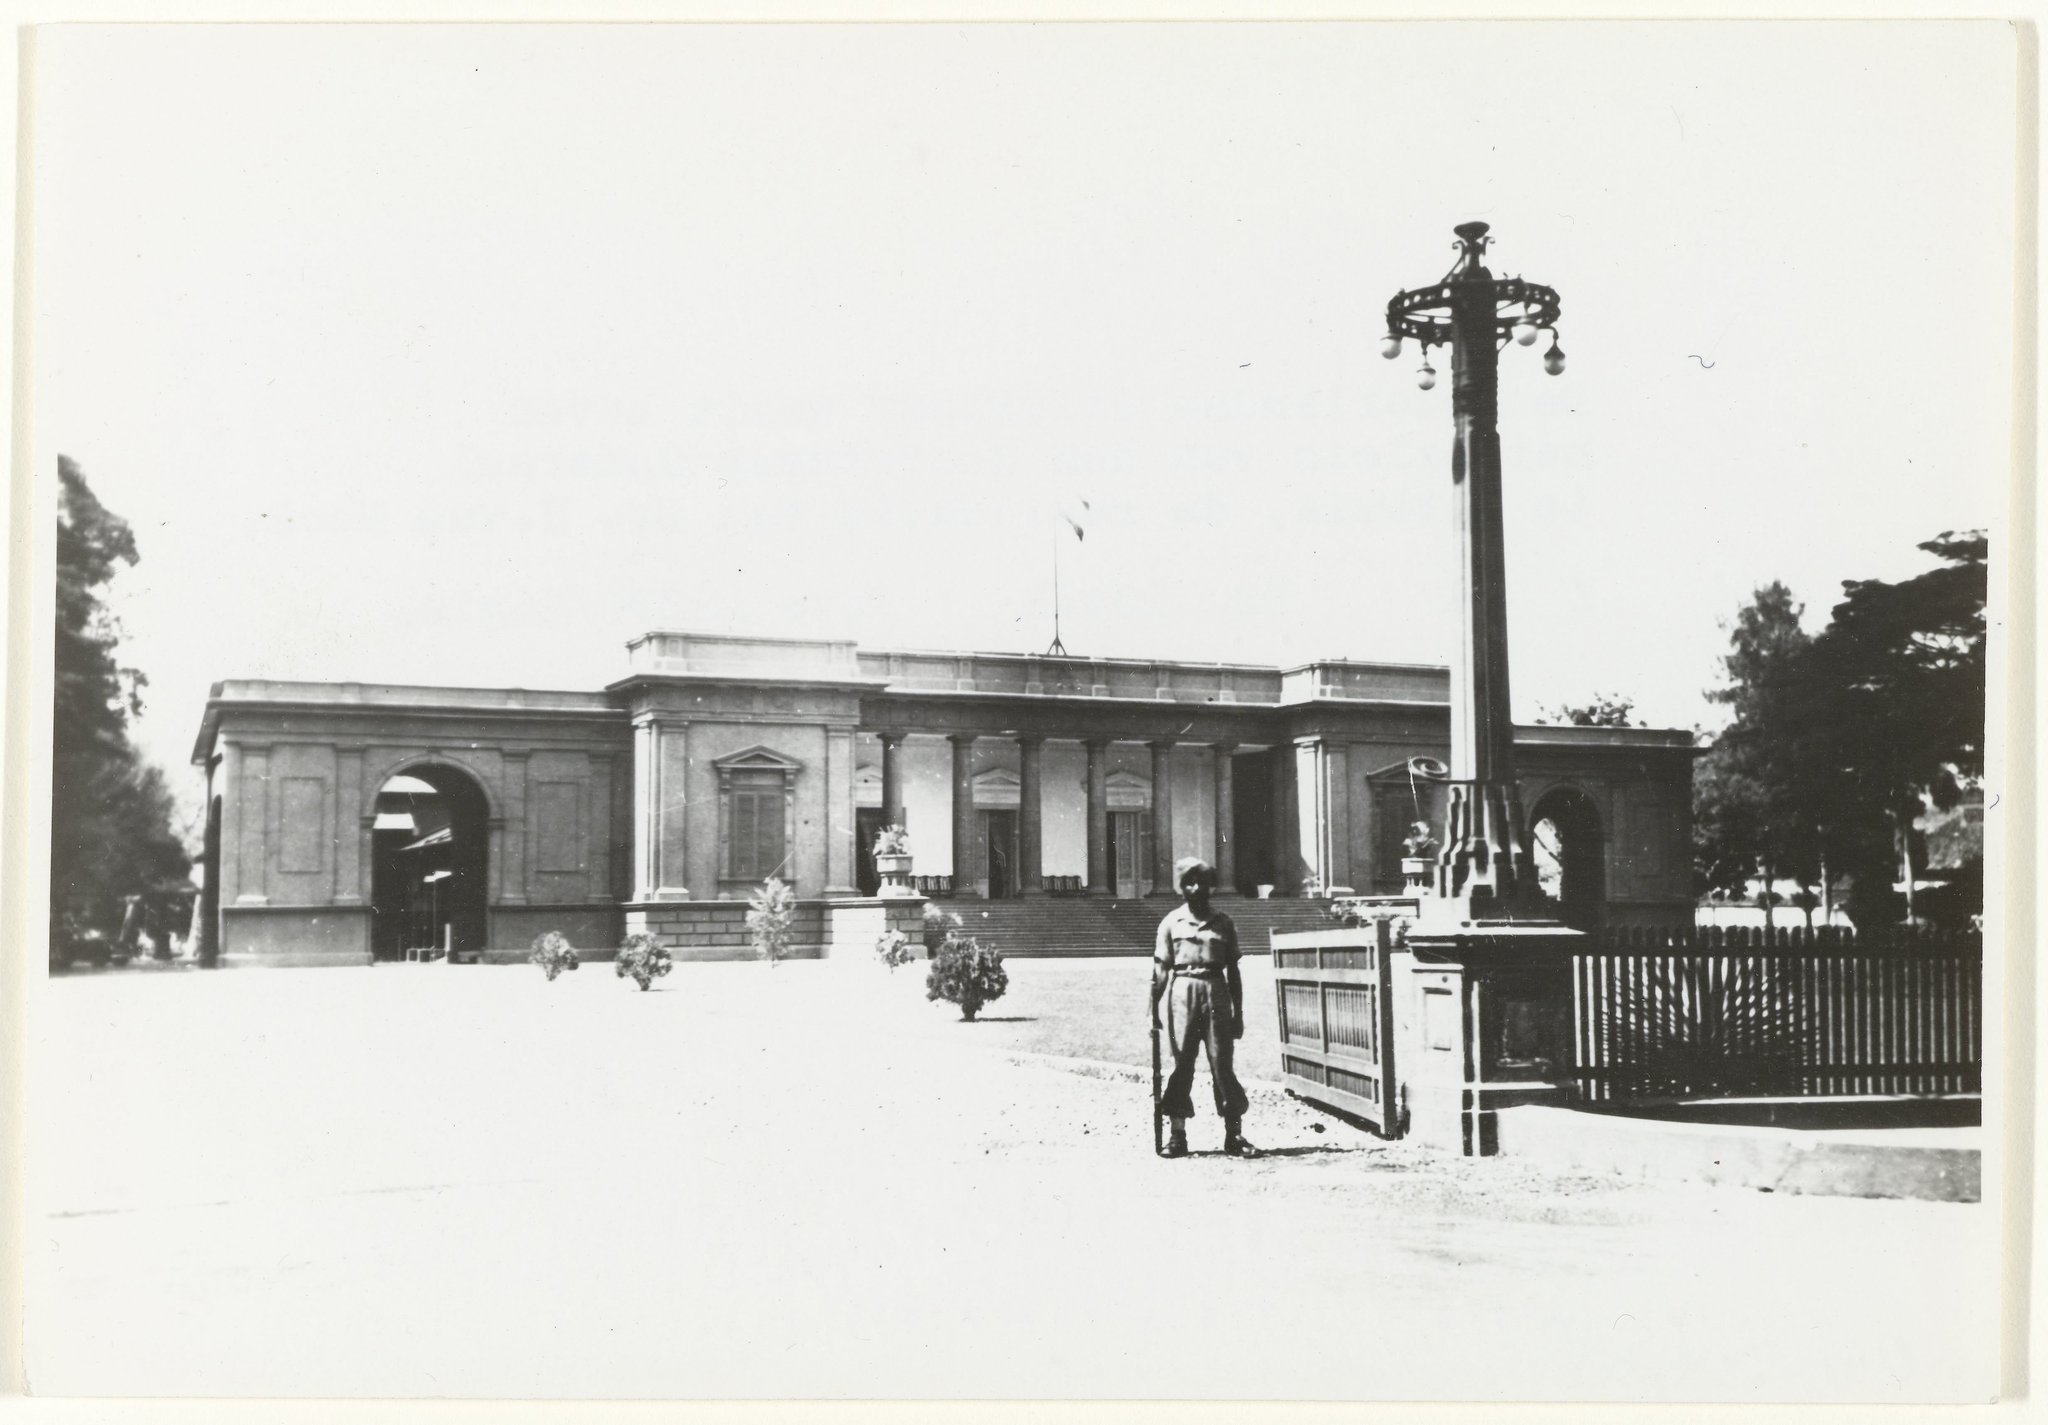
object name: photograph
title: Residentie van Gouverneur-Generaal H. van Mook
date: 1945-1946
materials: photographic support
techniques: photography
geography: indonesia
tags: france, hubertus johannes van mook, batavia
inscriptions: stamp: ‘COPYRIGHT / 'ANEFO' / ALGEMEEN NEDERLANDSCH FOTOBUREAU’, inscription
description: Paleis van Gouverneur-Generaal, residentie GG H. van Mook.